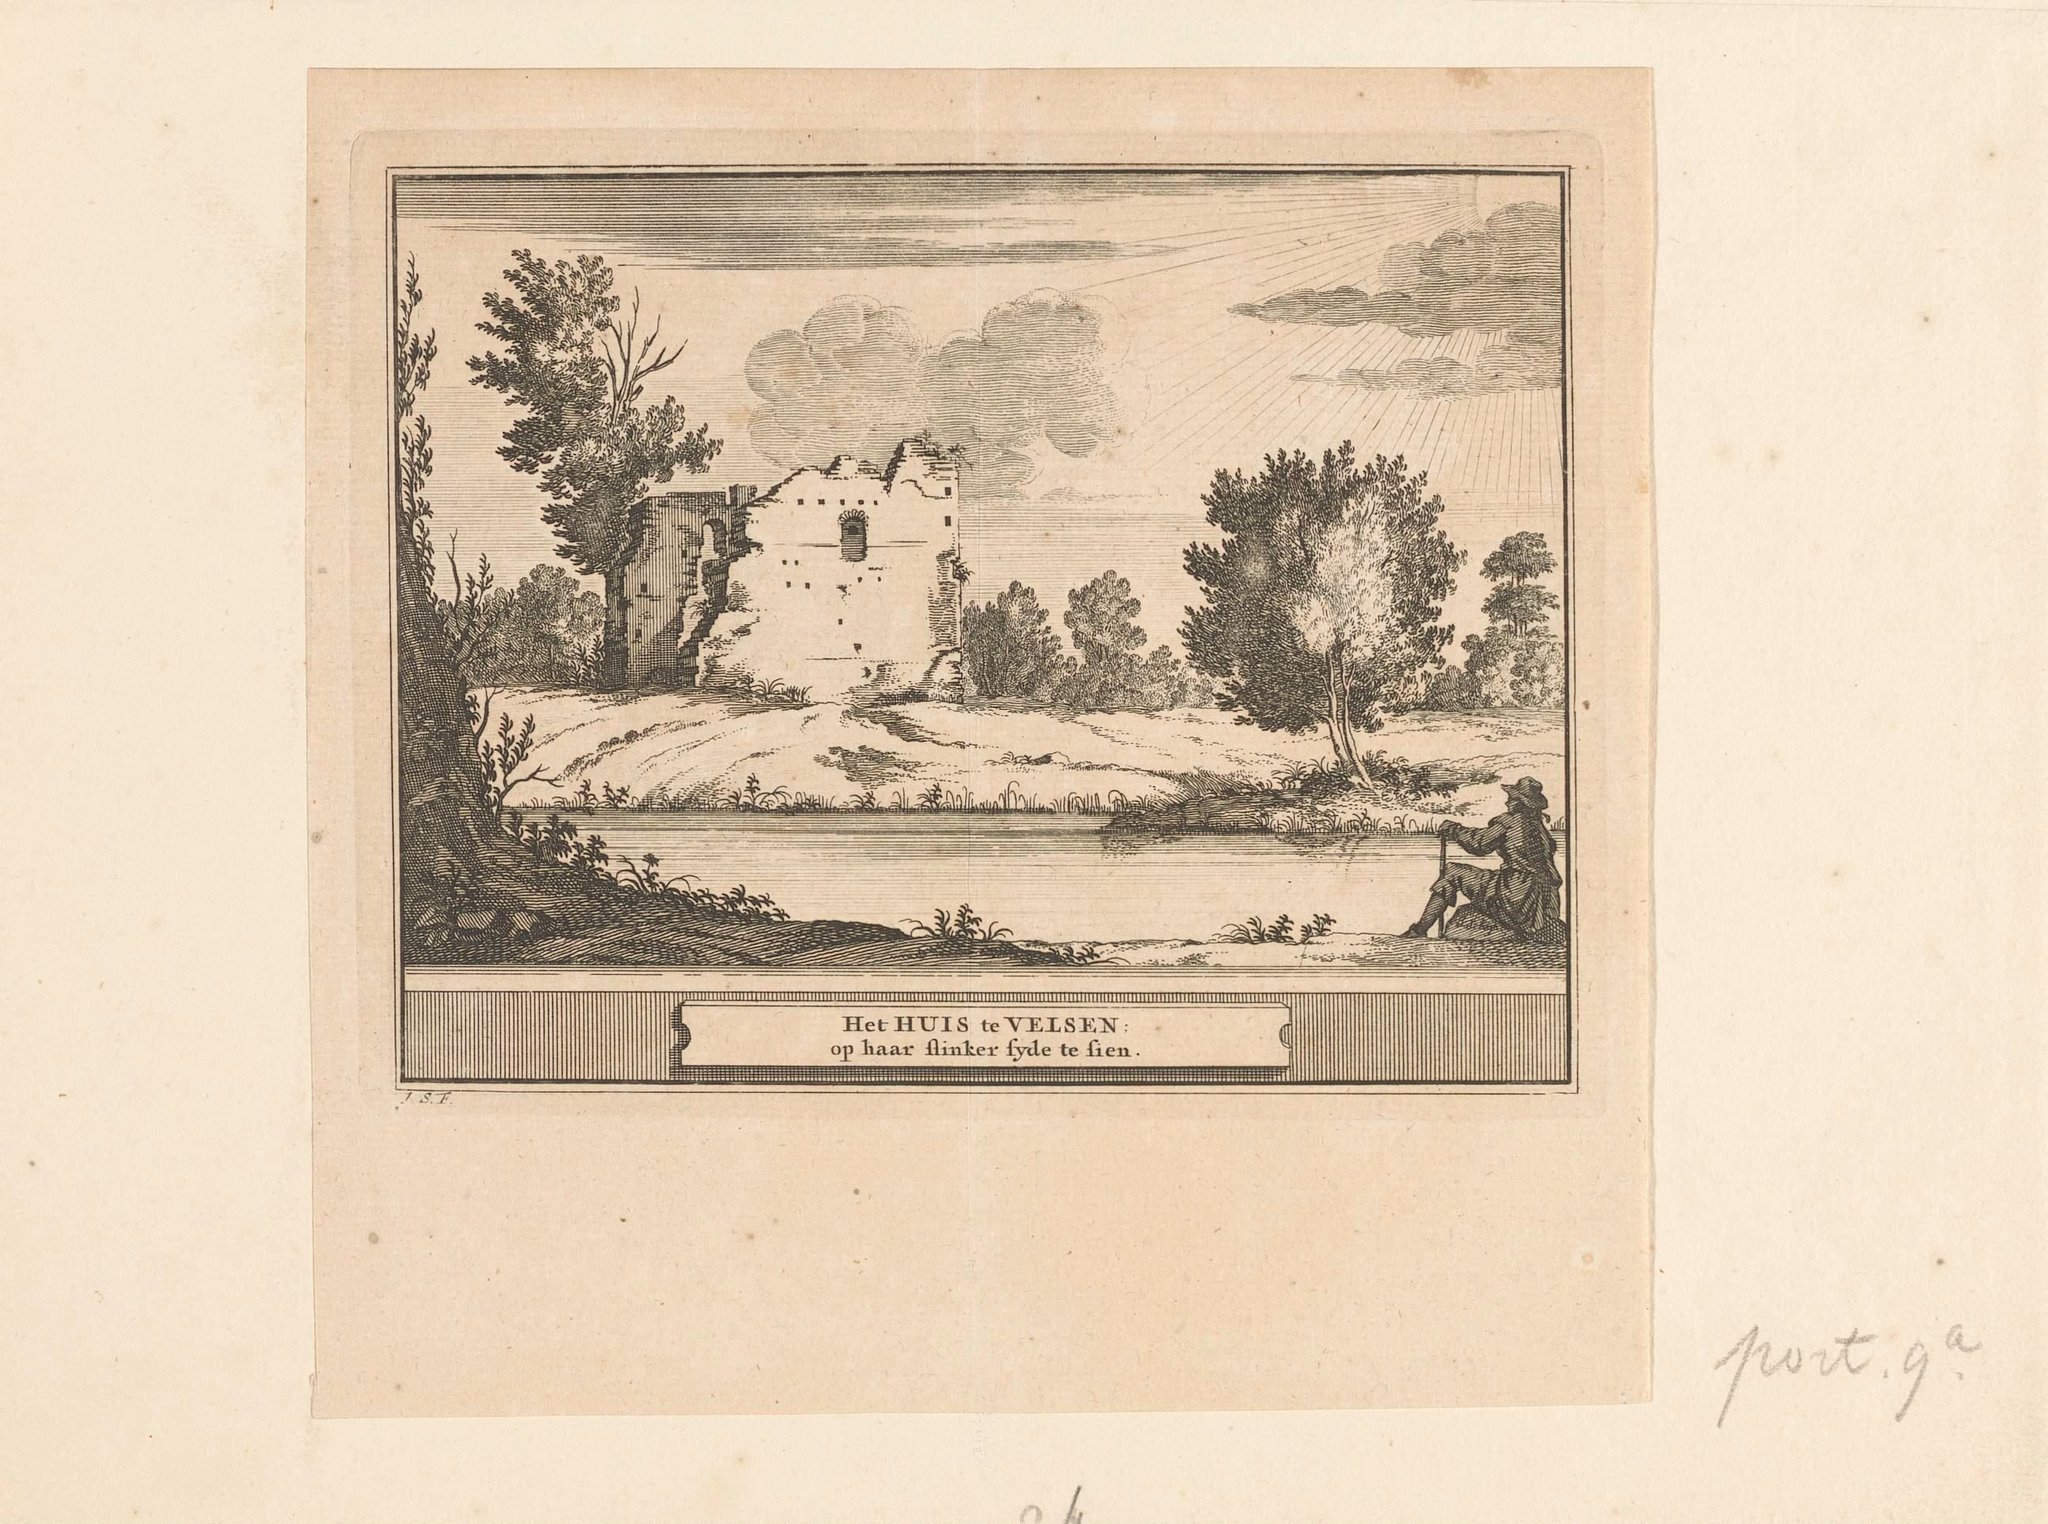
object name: print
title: Het huis te Velsen; op haar slinker syde te sien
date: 1711-1774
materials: paper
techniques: engraving, etching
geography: amsterdam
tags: ruin of a dwelling, house, castle, etc.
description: Prent ook gebruikt in: Smids, Ludolf. Schatkamer der Nederlandsse oudheden; of woordenboek, behelsende Nederlands steden en dorpen, kasteelen, sloten en heeren huysen (…). Amsterdam: Pieter de Coup, 1711, tussen p. 350 en 351. Het is ook mogelijk dat deze prent uit de tweede (1737) of derde (1774) druk komt, of uit een uitgave met alleen de prenten: Nederlandsche oudheden, bestaande in zestig verbeeldingen (...) gelegen in Holland, 't Sticht van Utrecht en Gelderland enz. Amsterdam: Hendrik Bosch, 1721.